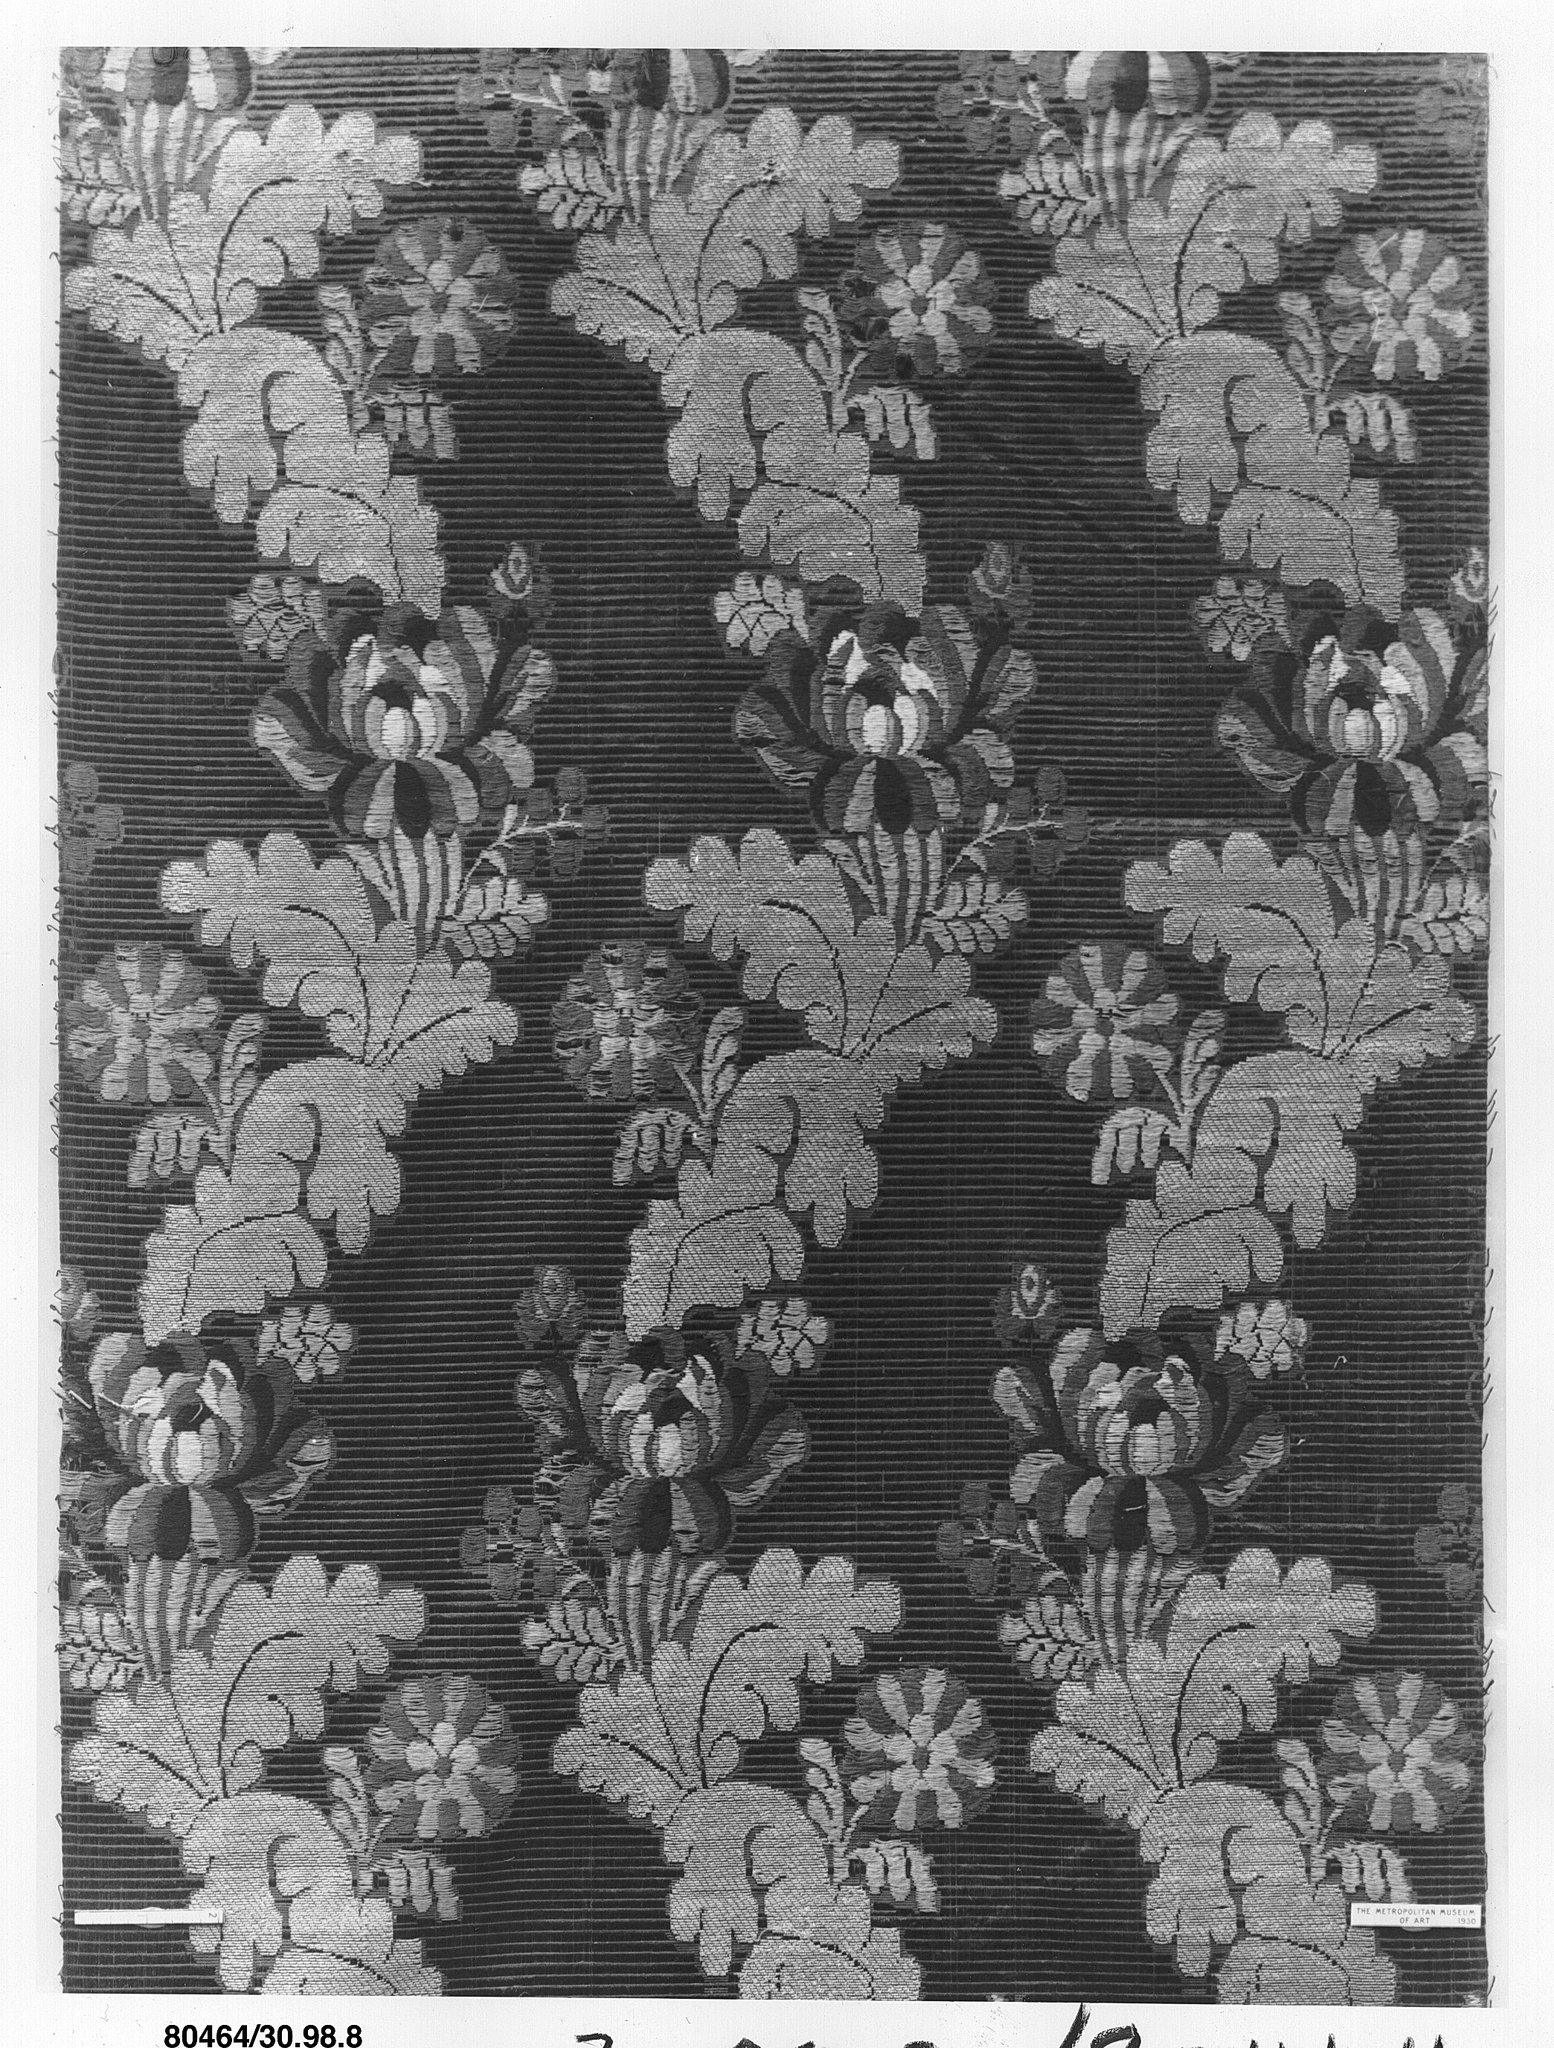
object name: piece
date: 1701-1800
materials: metal thread, silk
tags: flowers,leaves